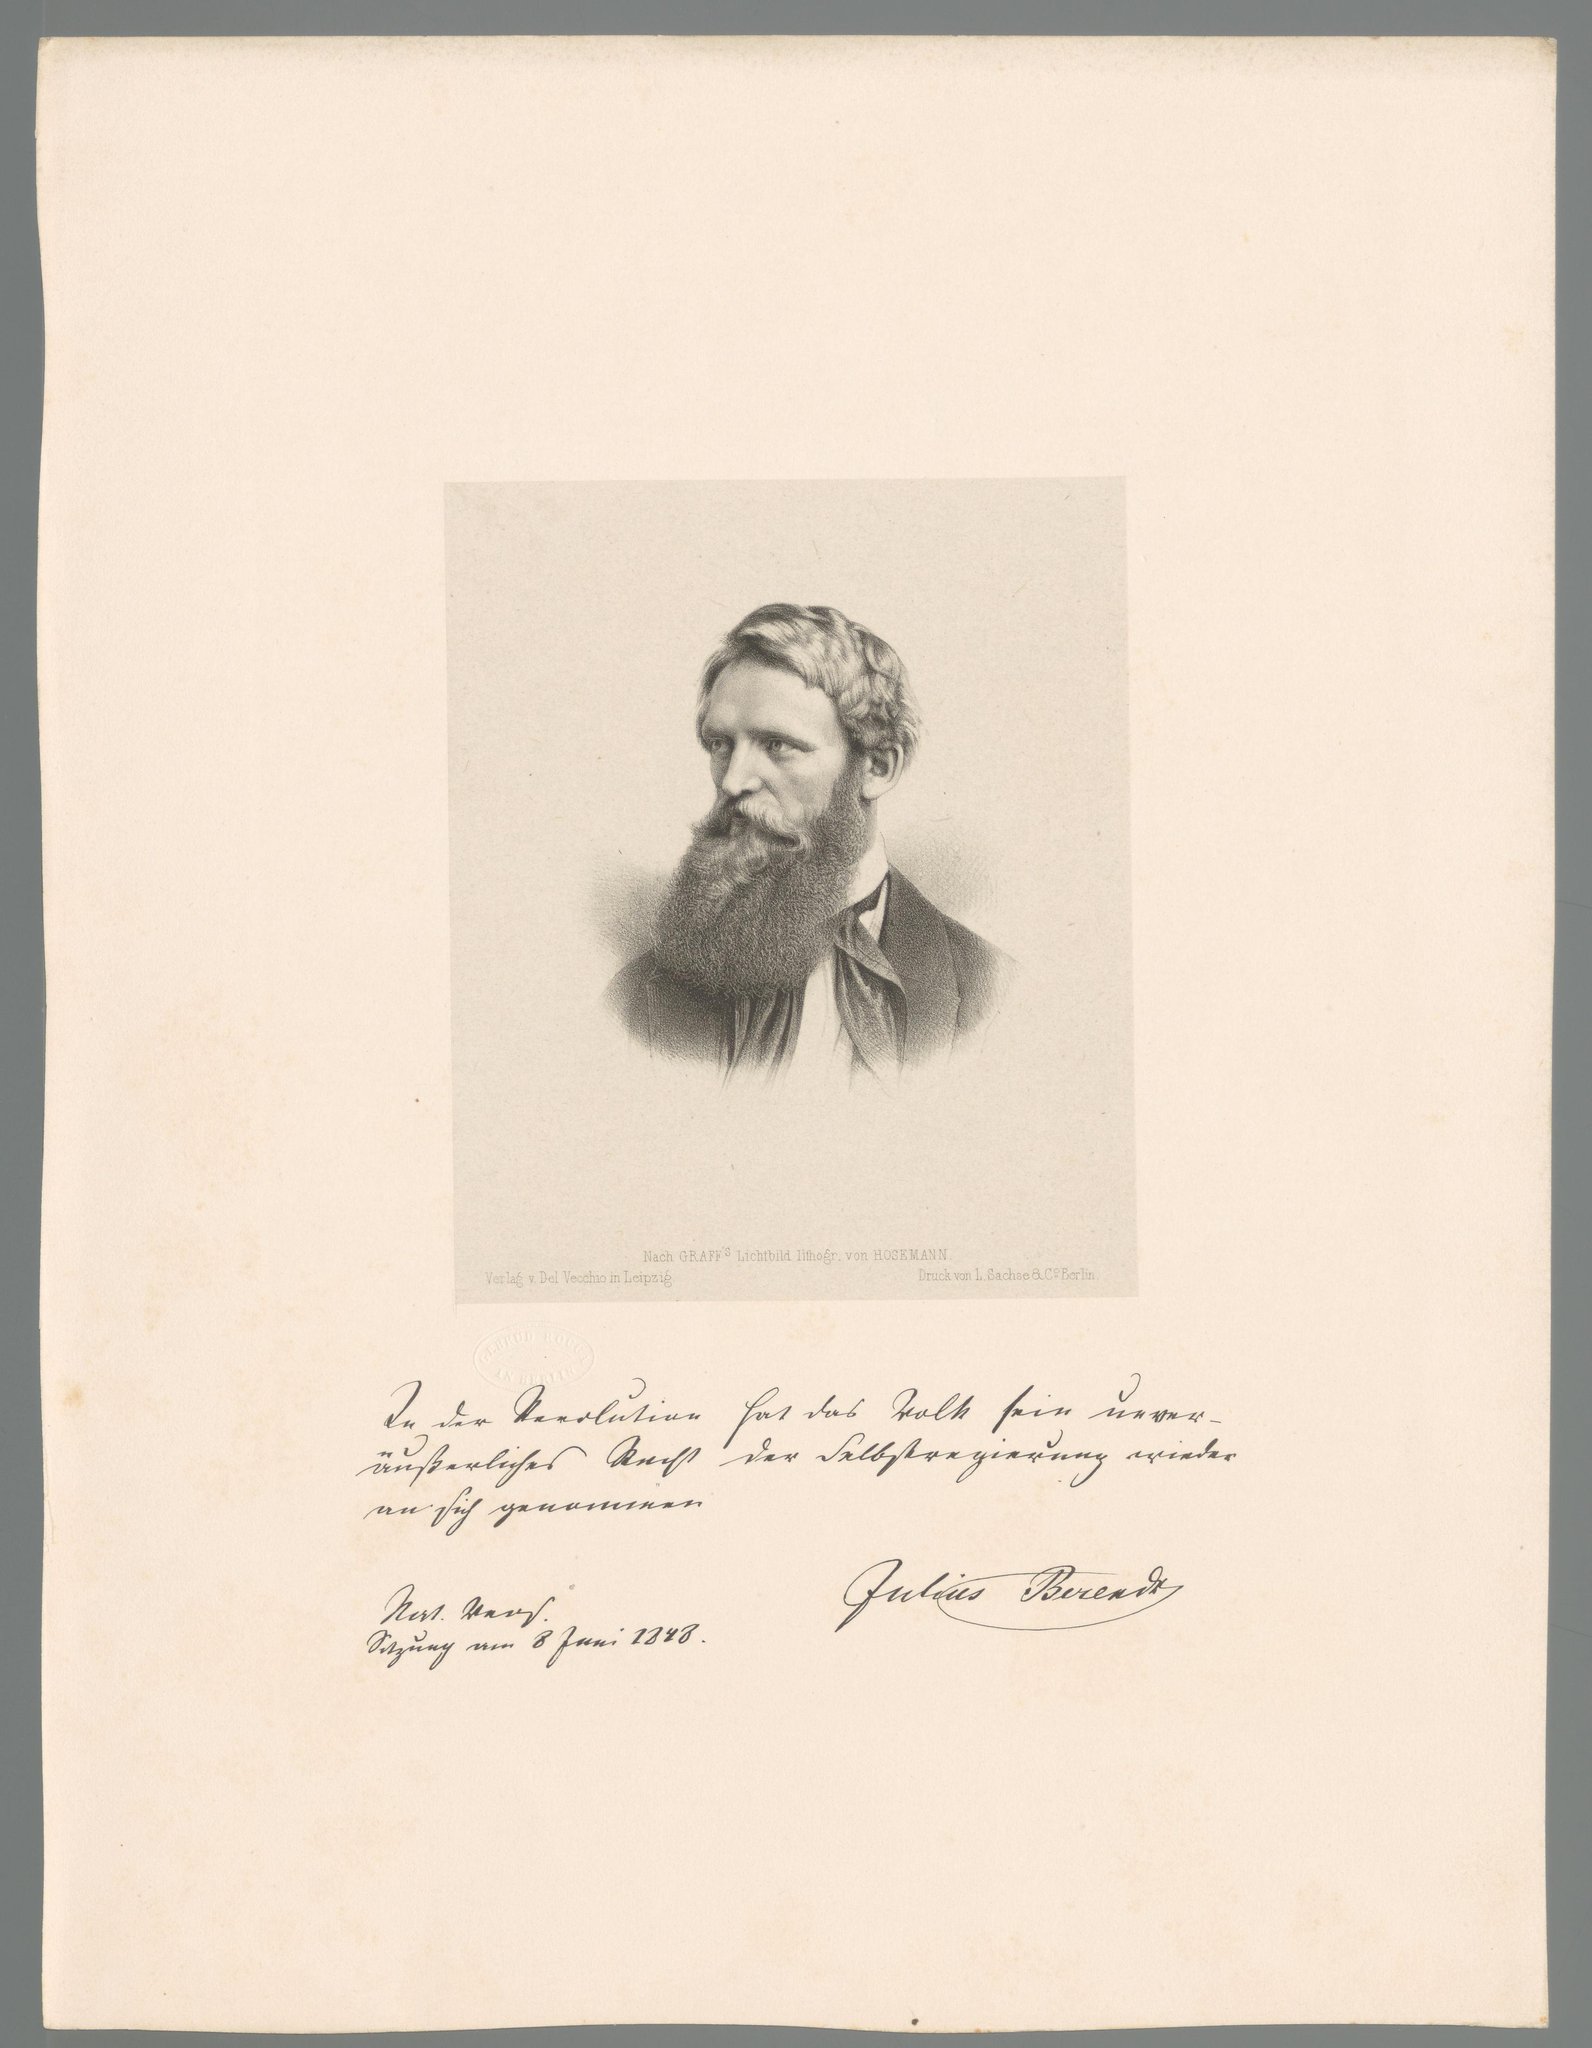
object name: print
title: Portret van Julius Berends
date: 1848-1875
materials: paper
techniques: lithograph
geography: berlin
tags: politician, julius berends, adult man, historical persons, beard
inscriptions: collector's mark: Lugt 2228, check stamp: Lugt 2141c